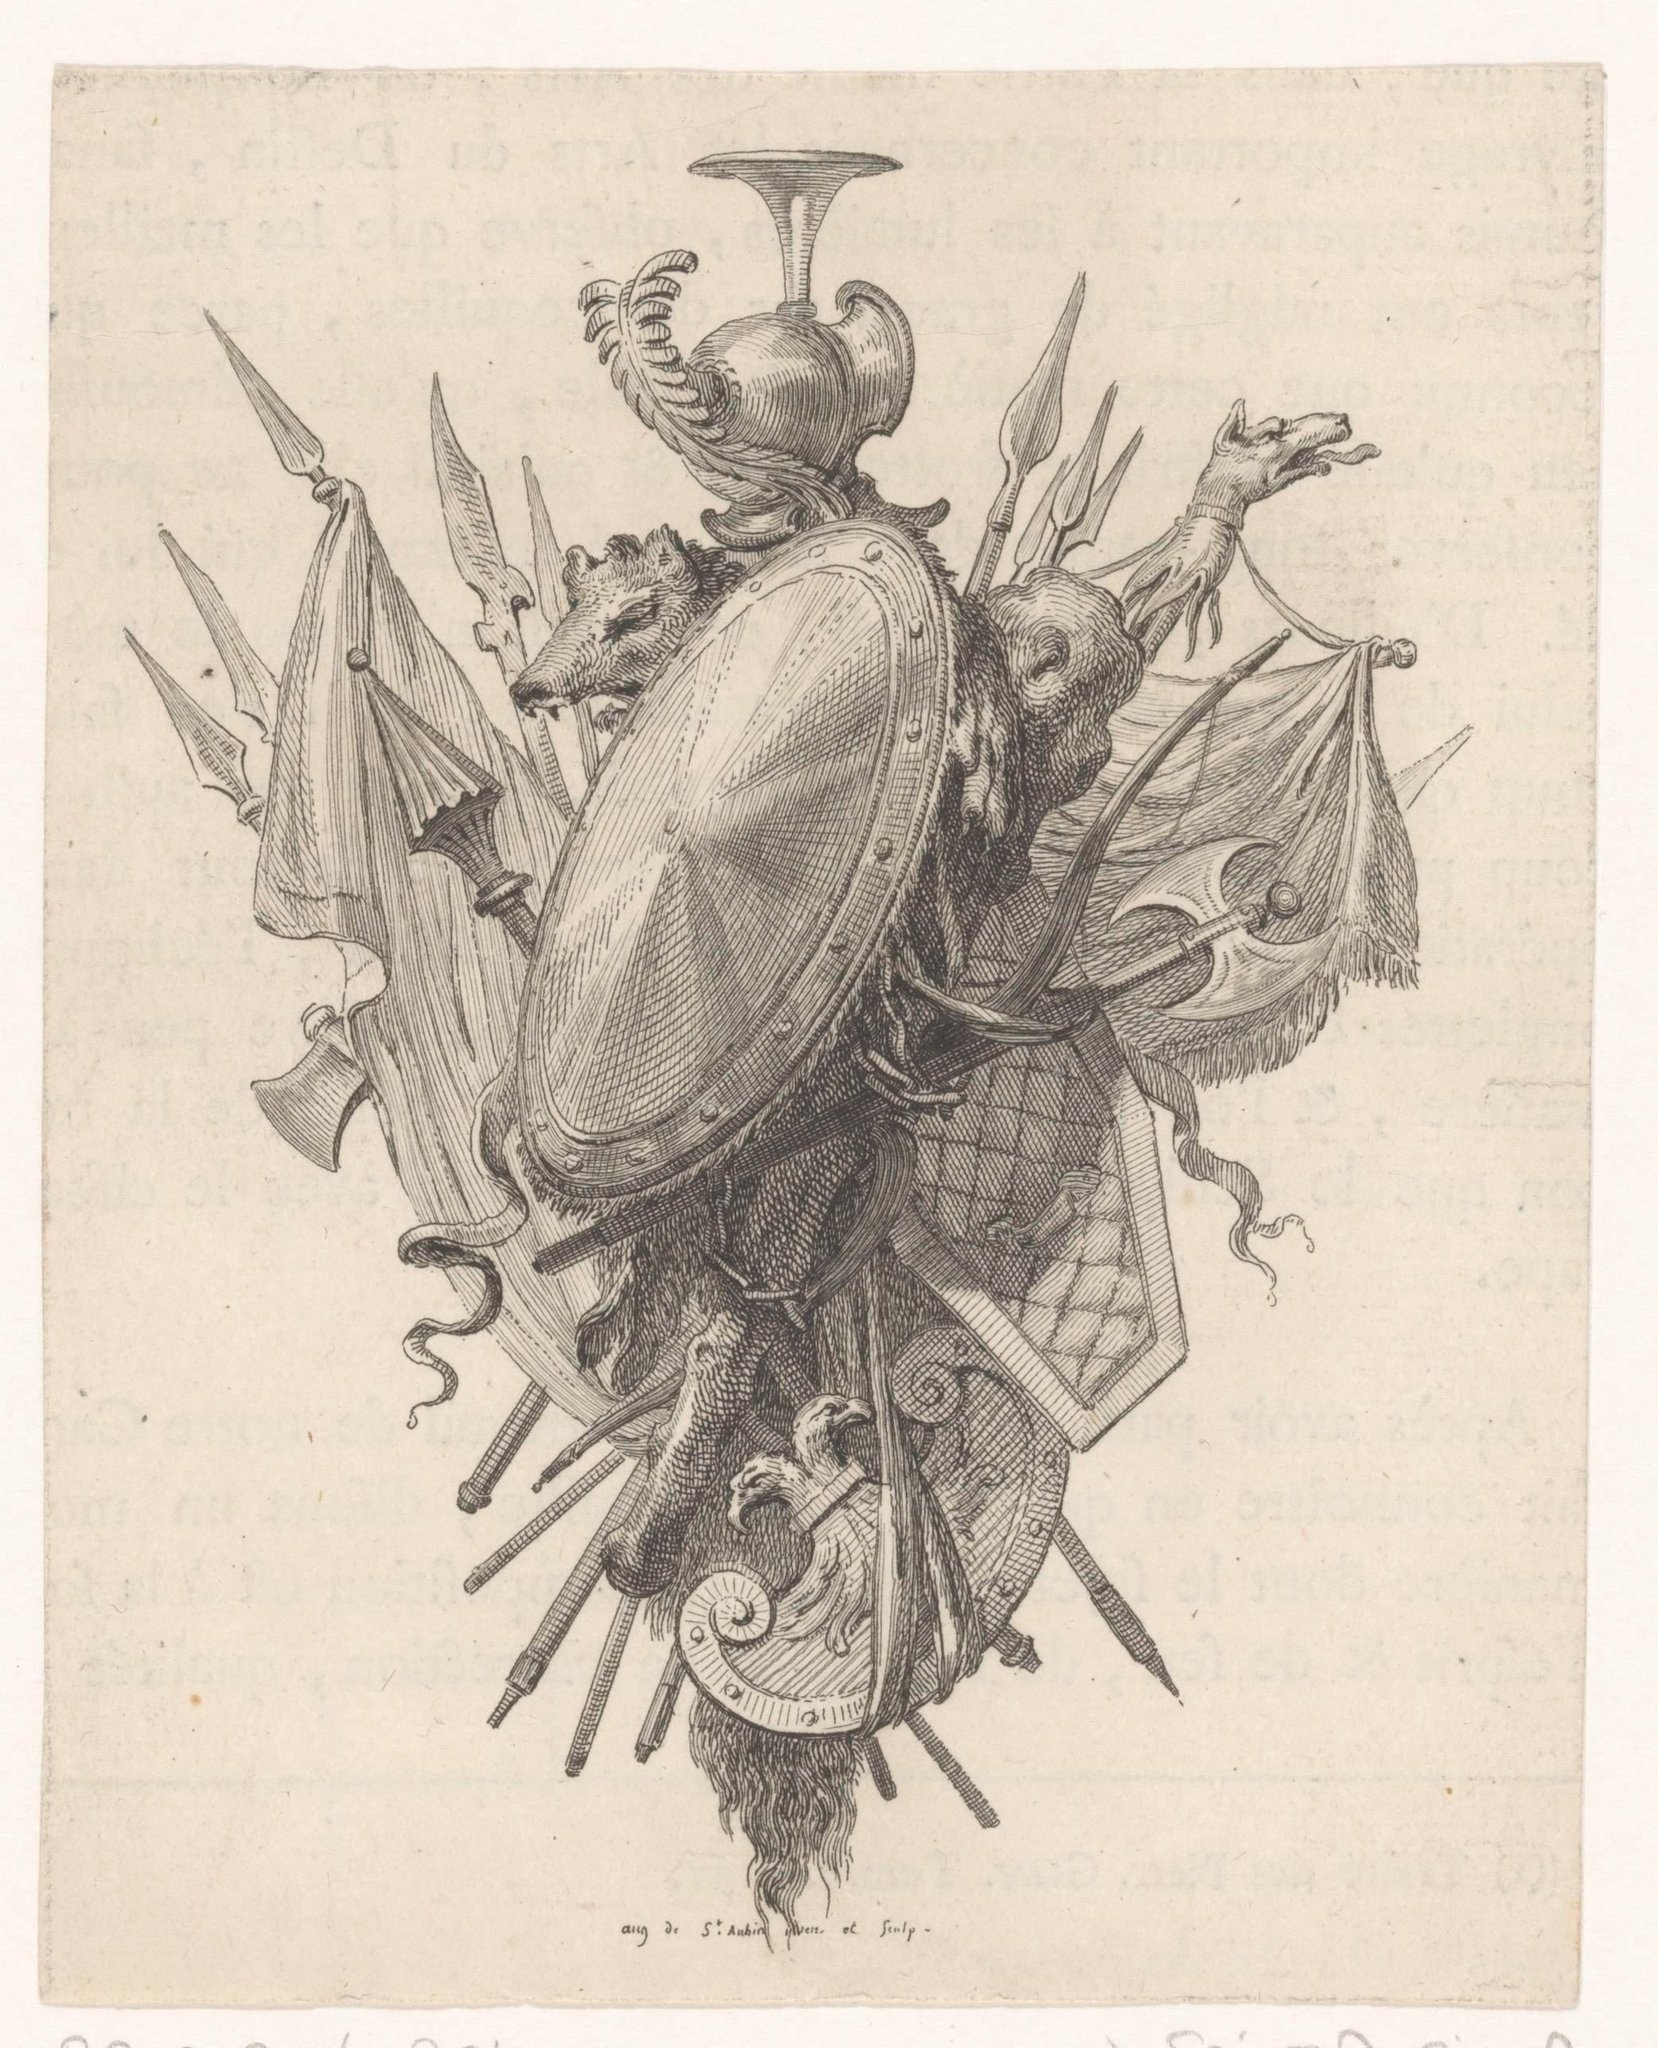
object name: print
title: Wapentrofee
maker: augustin de saint-aubin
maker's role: draughtsman, print maker, publisher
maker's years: 1736-1807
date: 1746-1807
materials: paper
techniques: etching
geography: france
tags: 'tropaion', i.e. decorative ornament ~ weapons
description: Een wapentrofee met vlaggen, schilden, een helm, een knots en een dierenvel mogelijk van een leeuw.